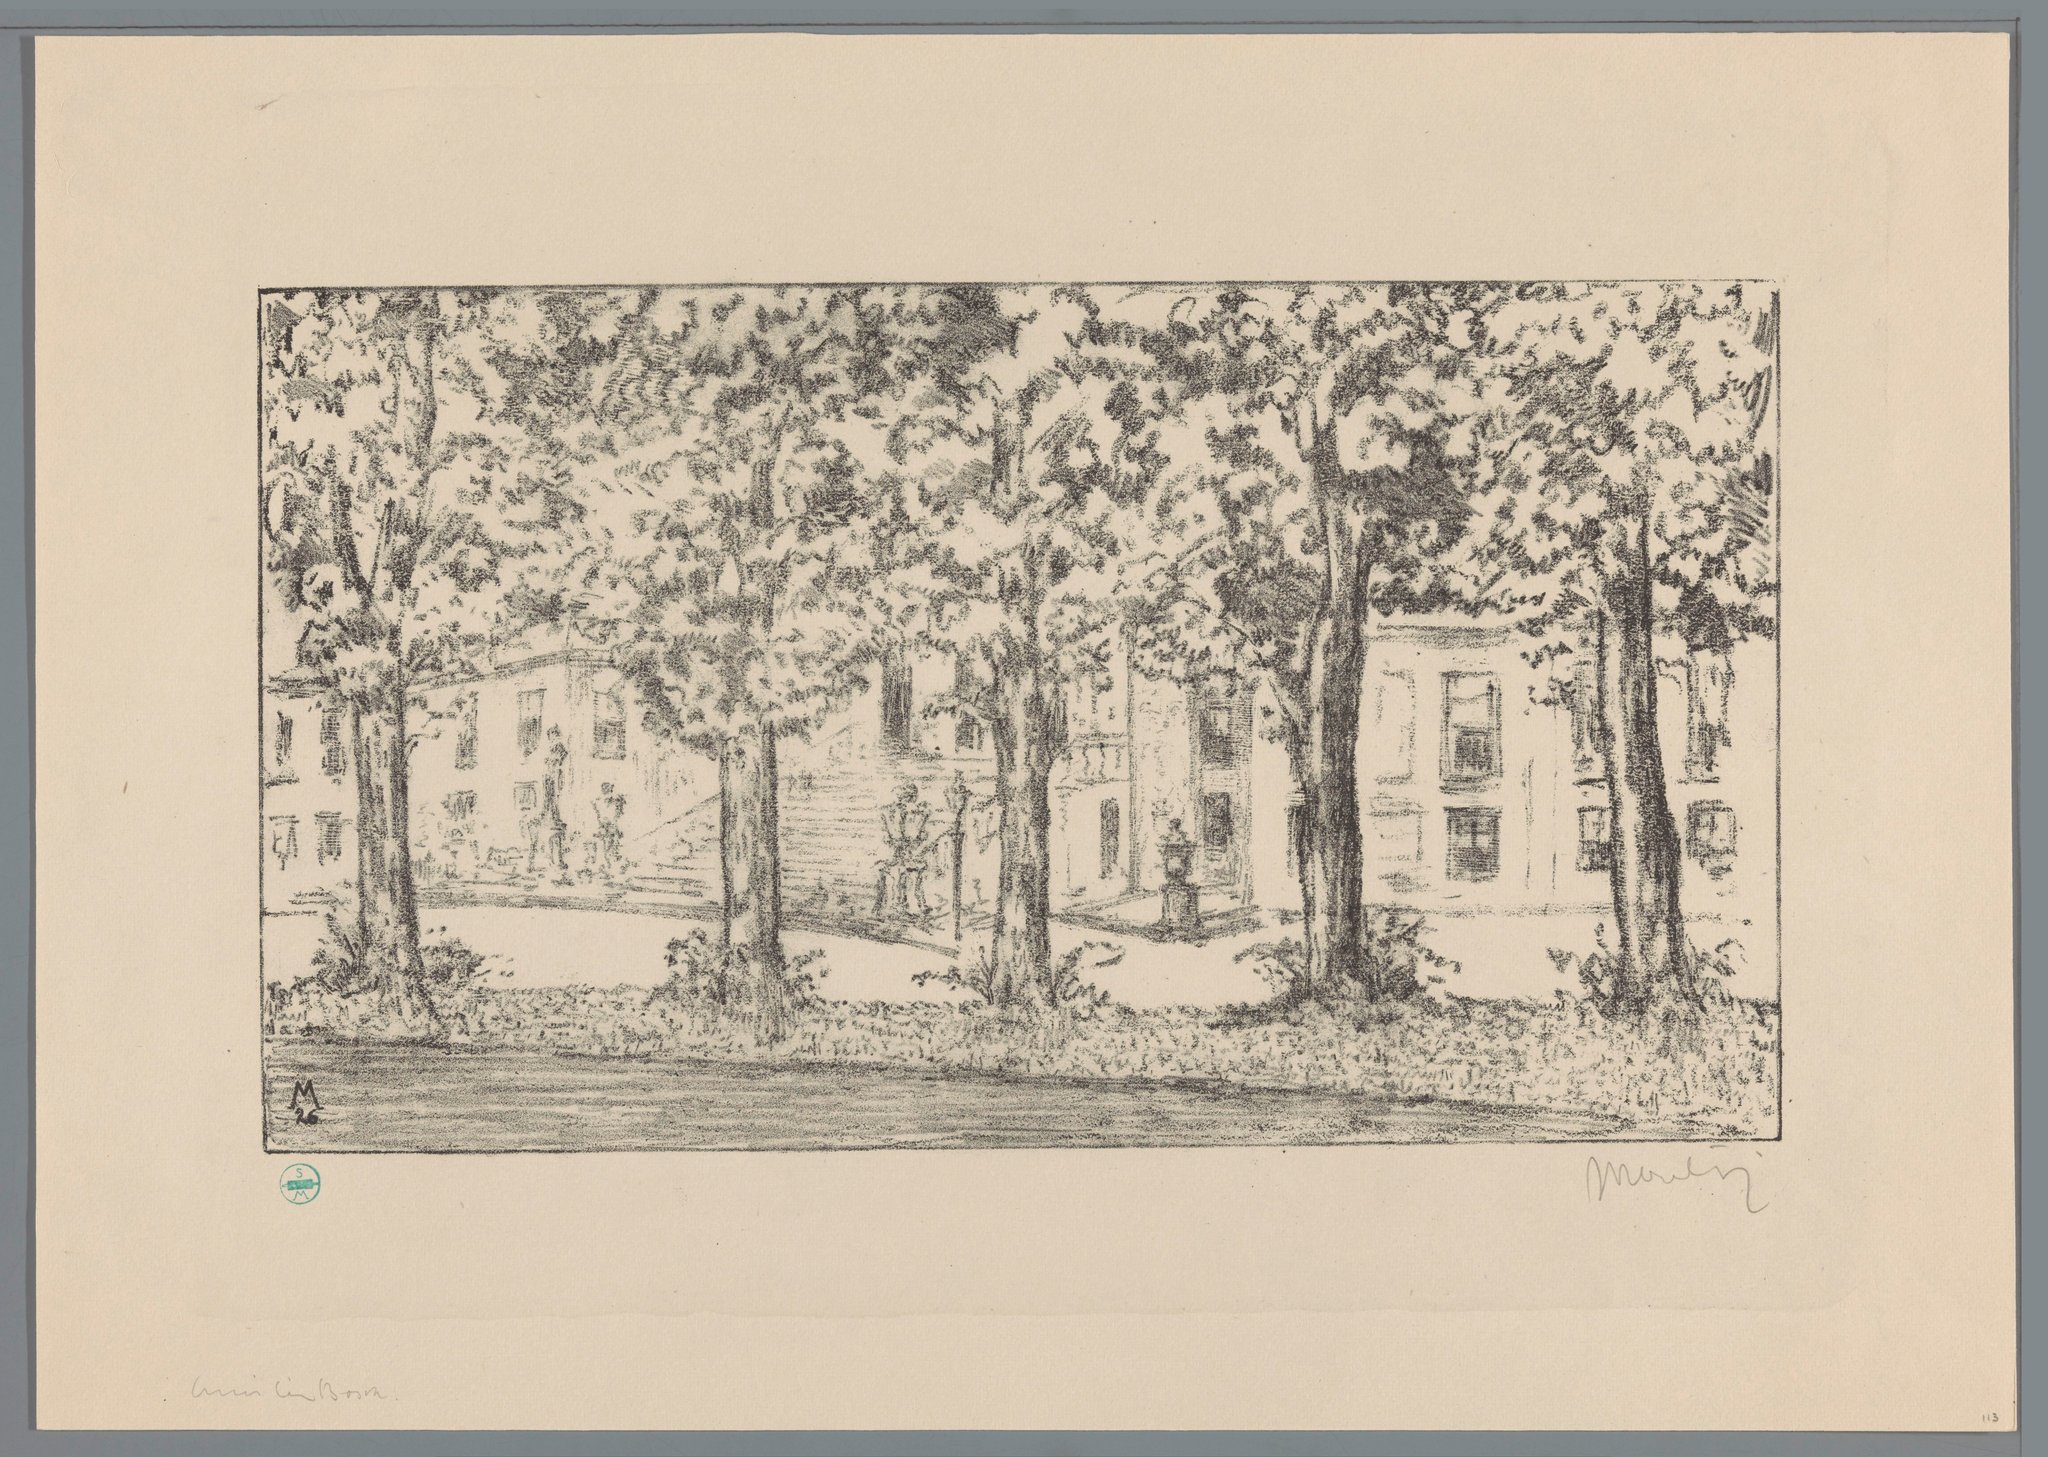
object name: print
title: Gezicht op het bordes van Paleis Huis ten Bosch tussen een rij bomen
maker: simon moulijn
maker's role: draughtsman, print maker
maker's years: 1866-1948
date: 1926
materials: paper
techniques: lithograph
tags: palace, terrace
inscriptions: stamp: Lugt 2362b, collector's mark: Lugt 2228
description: Prent gebruikt voor: Moulijn, Simon en Gelder, Hendrik Enno van. Oude buitenplaatsen rondom 's-Gravenhage. 's-Gravenhage: Gemeentebestuur, 1929.